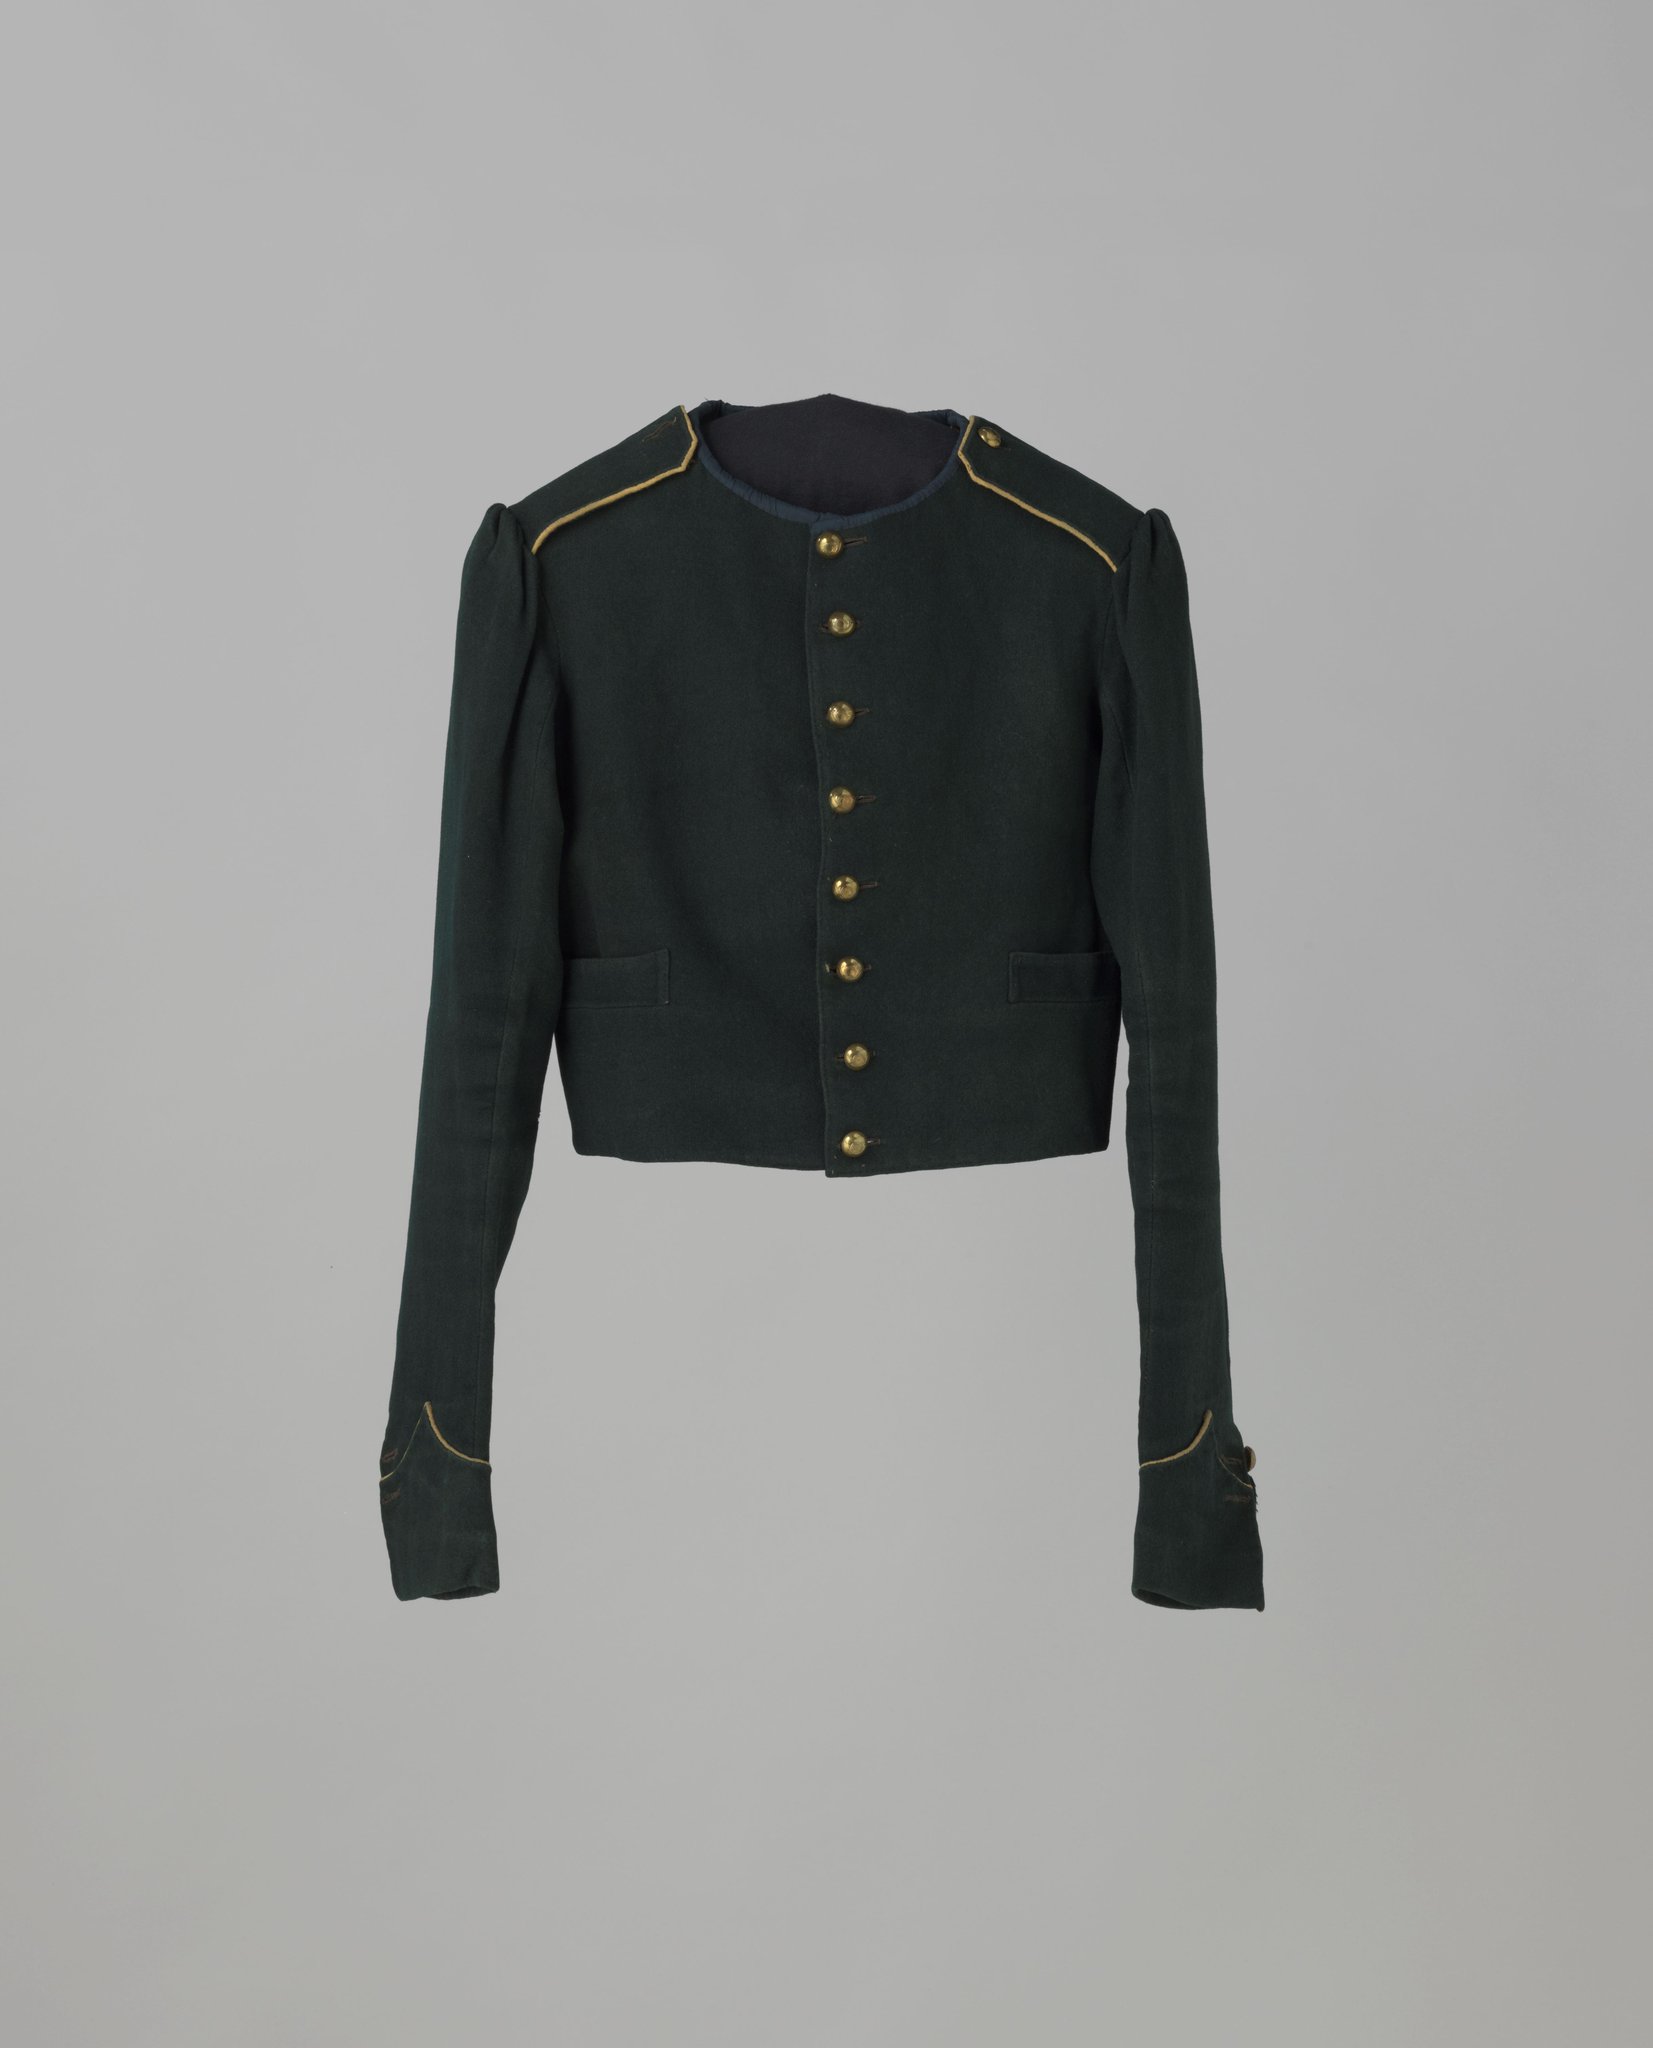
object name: cardigan waistcoat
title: Mouwvest van het regiment Jagers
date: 1829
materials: textile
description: Mouwvest behorende bij korporaalsrok van het Regiment Jagers. Zonder kraag. Het vest sluit met acht knopen. Twee zakken.